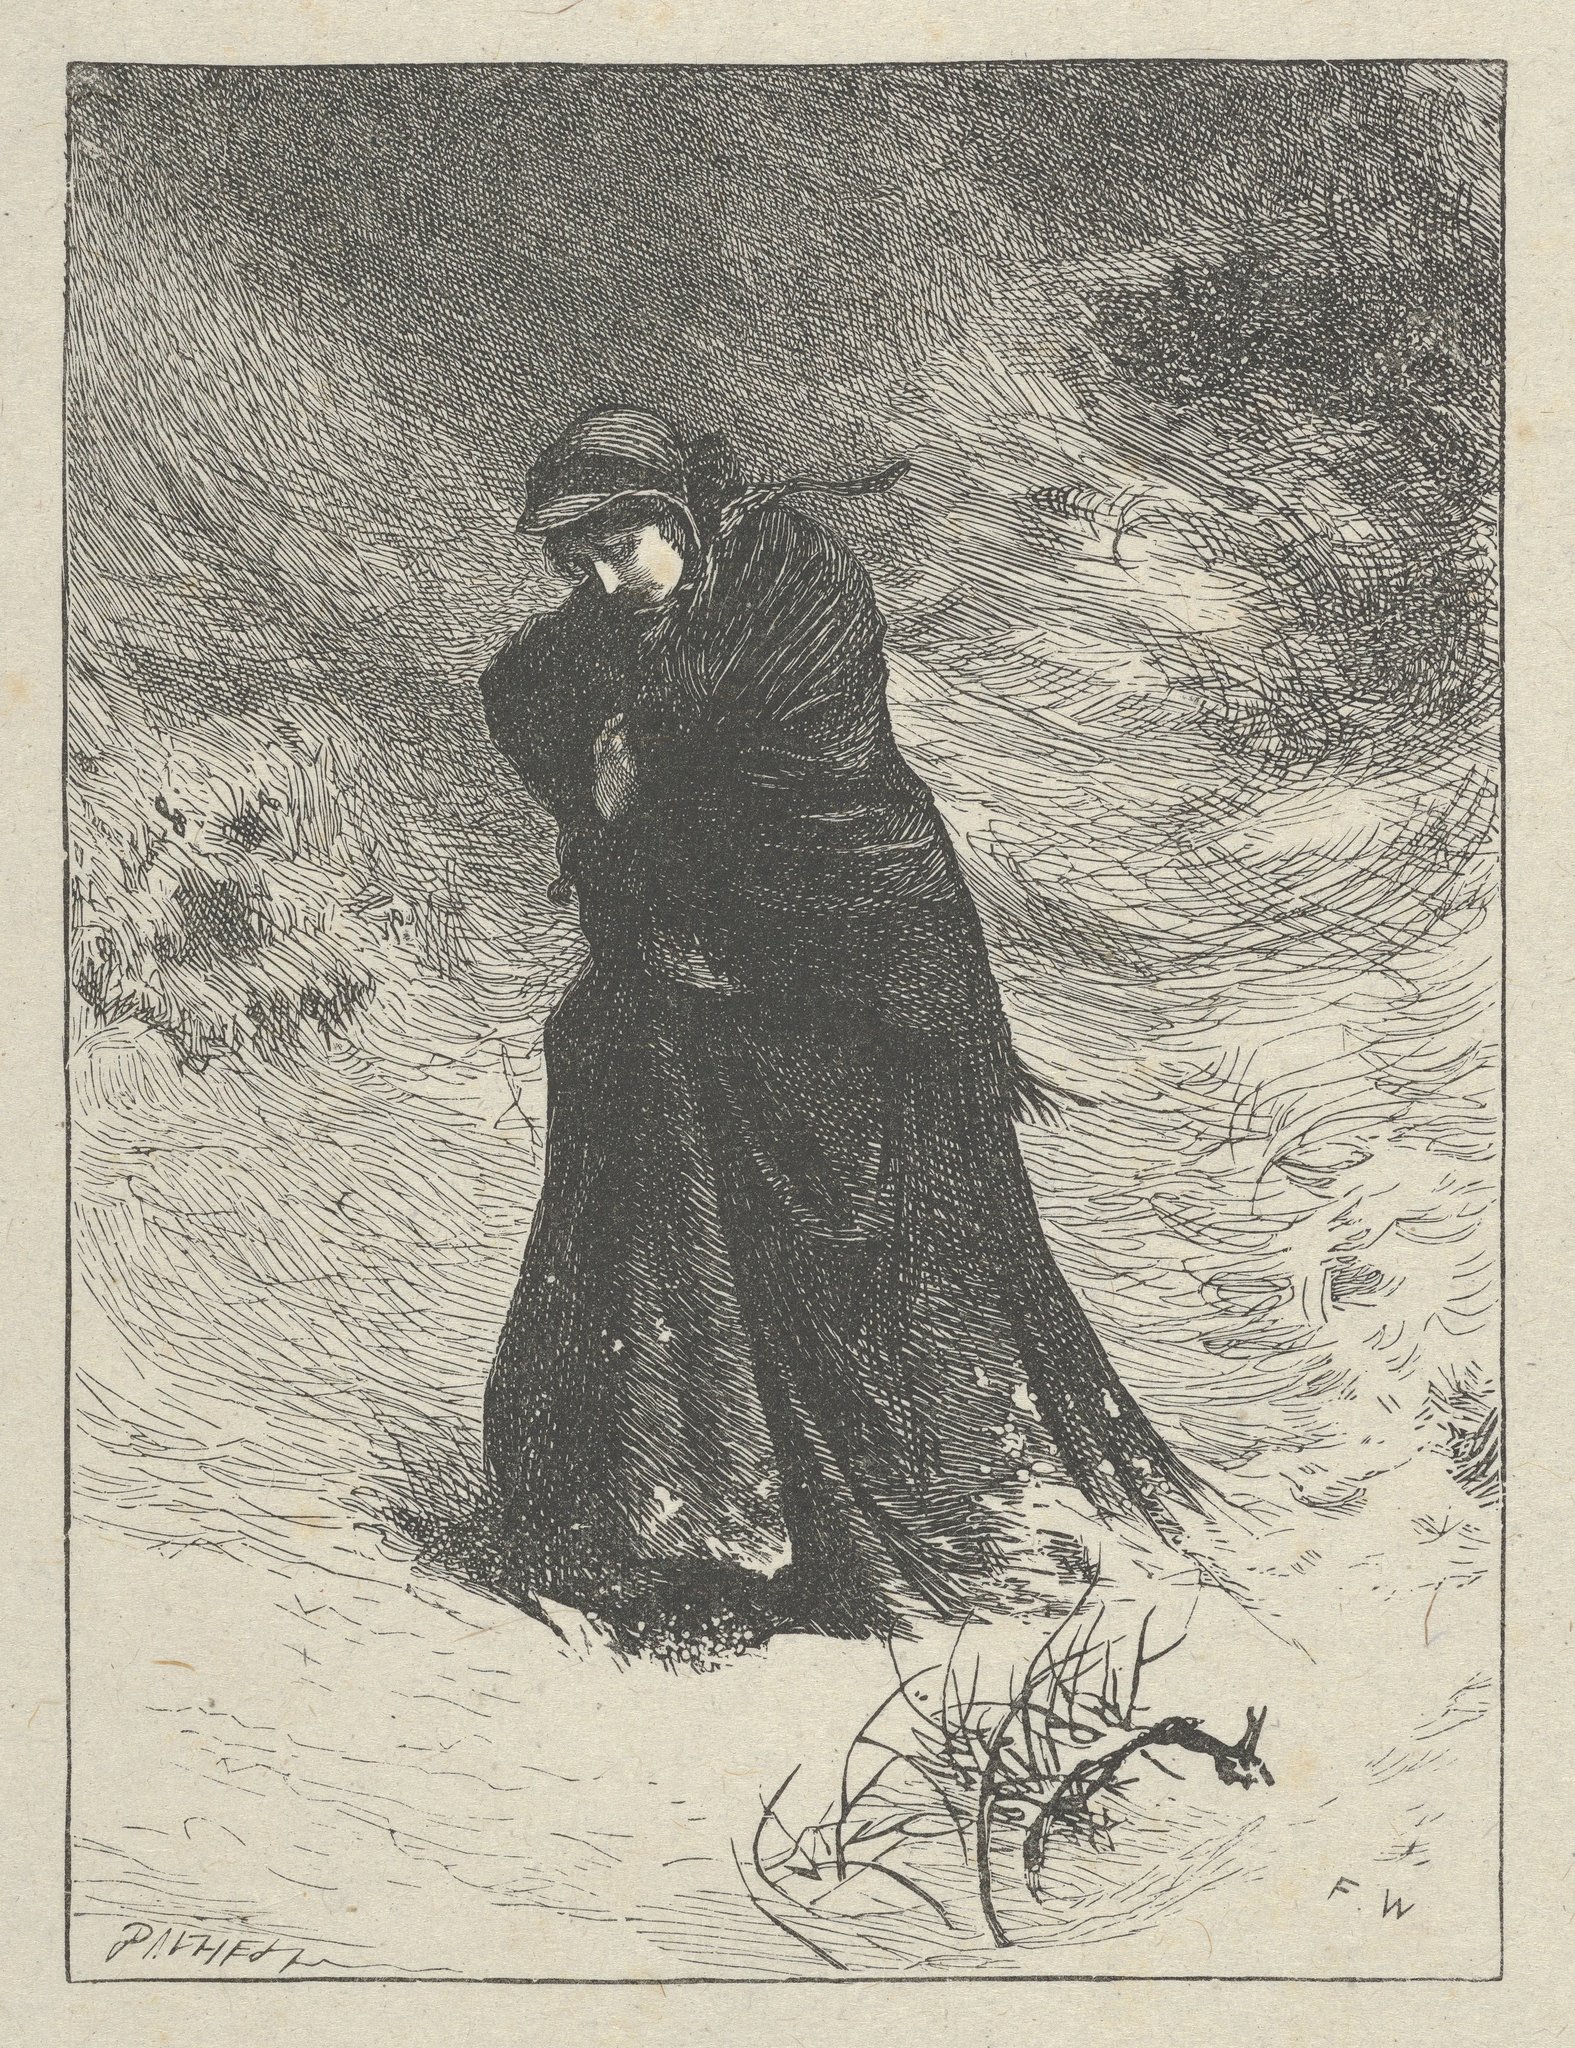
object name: print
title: Love in Death, for "Good Words"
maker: frederick walker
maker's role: artist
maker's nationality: british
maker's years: 1840-1875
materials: chine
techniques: engraving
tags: infants,women,snow